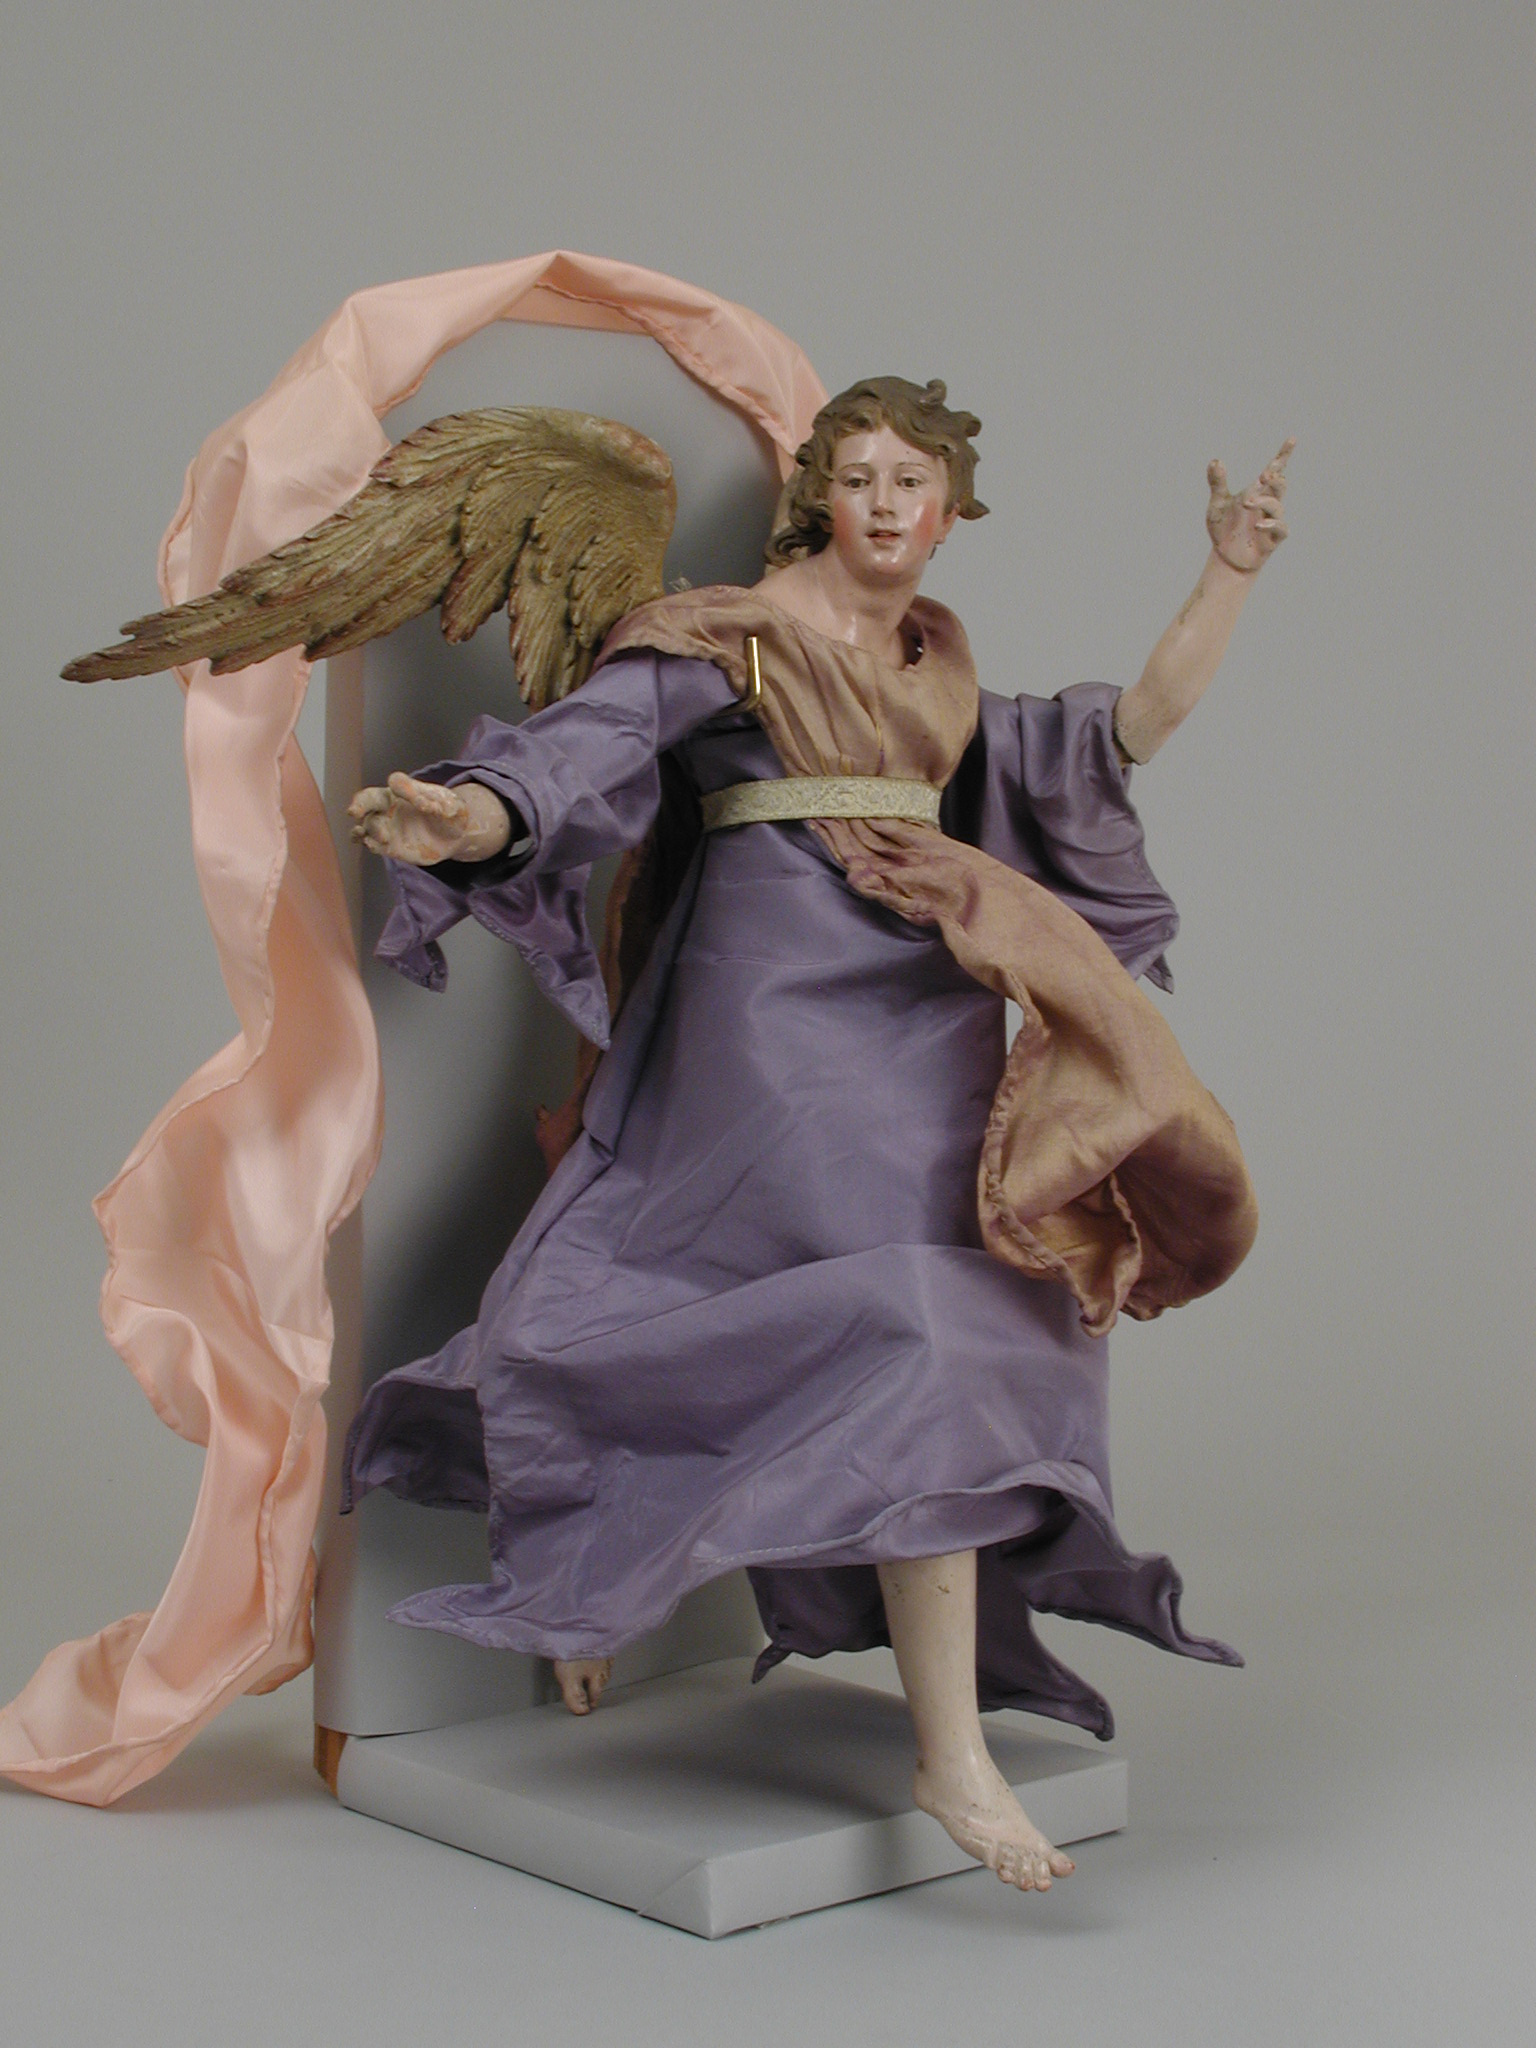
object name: crèche figure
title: Angel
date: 1751-1800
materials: terracotta, fiber, metal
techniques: polychrome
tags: angels